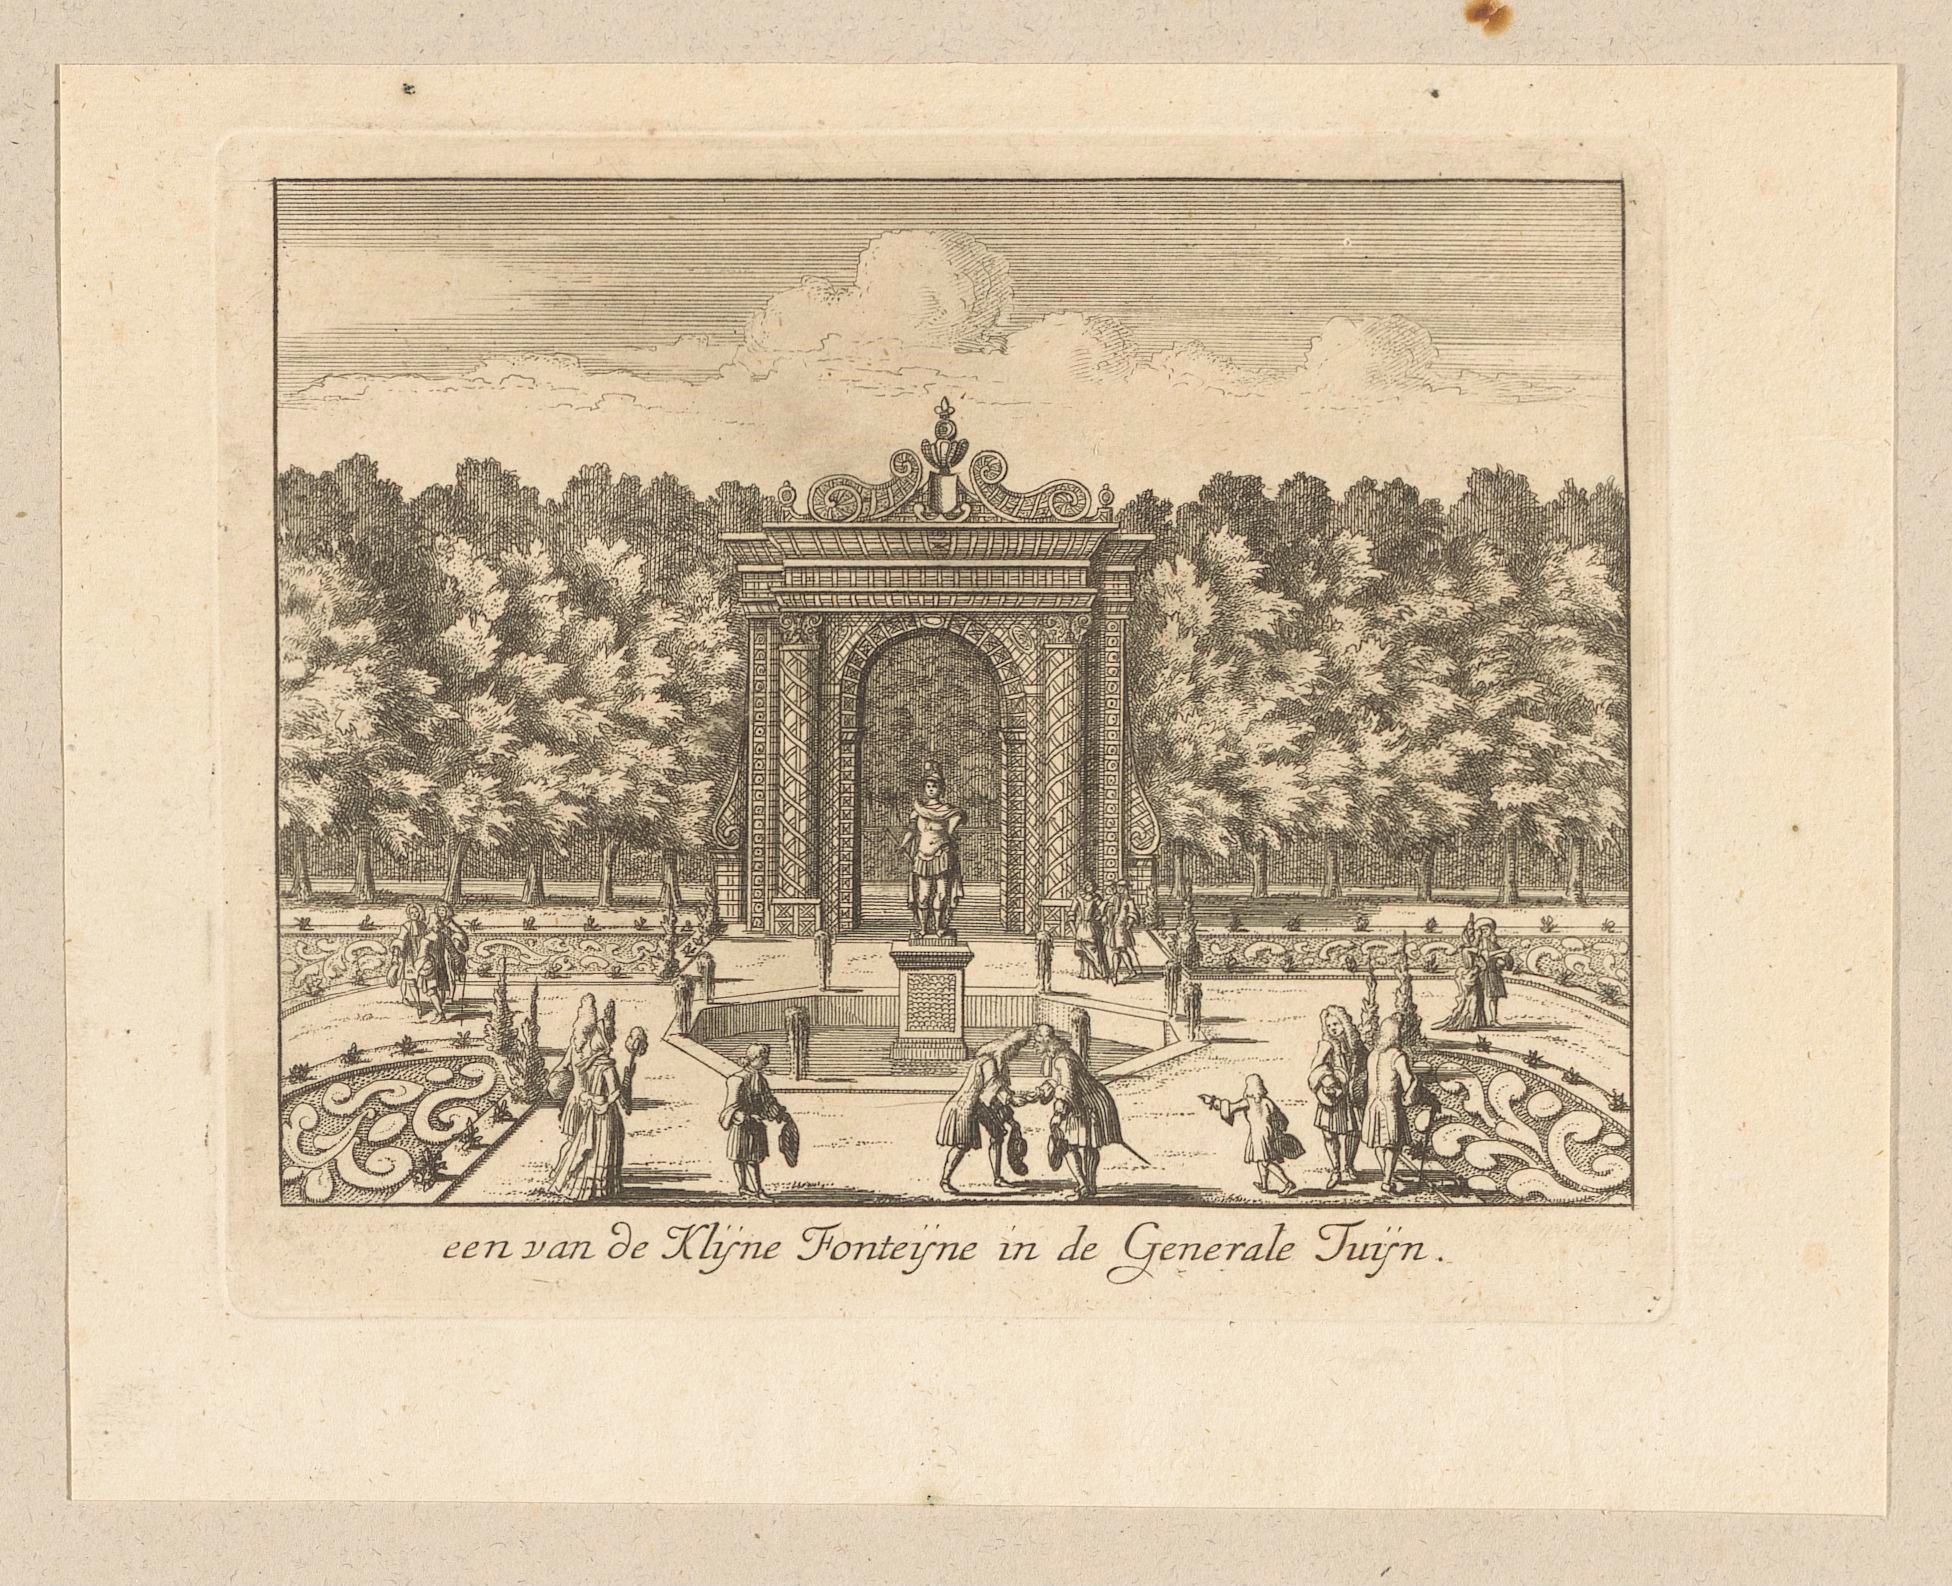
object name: print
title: Zestien prenten van Paleis Honselaarsdijk (Danckerts / Covens en Mortier)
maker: cornelis danckerts (ii)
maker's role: print maker, publisher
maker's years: 1664-1717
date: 1696-1717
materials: paper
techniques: etching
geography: amsterdam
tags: garden fountain, palace, french or architectonic garden; formal garden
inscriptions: collector's mark: Lugt 2233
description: Barokke tuin met een fontein. Op de lanen flaneren groepjes wandelaars. Op de achtergrond een stenen poort. Rechtsonder genummerd: 7. Prent uit een serie van zestien prenten van Paleis Honselaarsdijk.